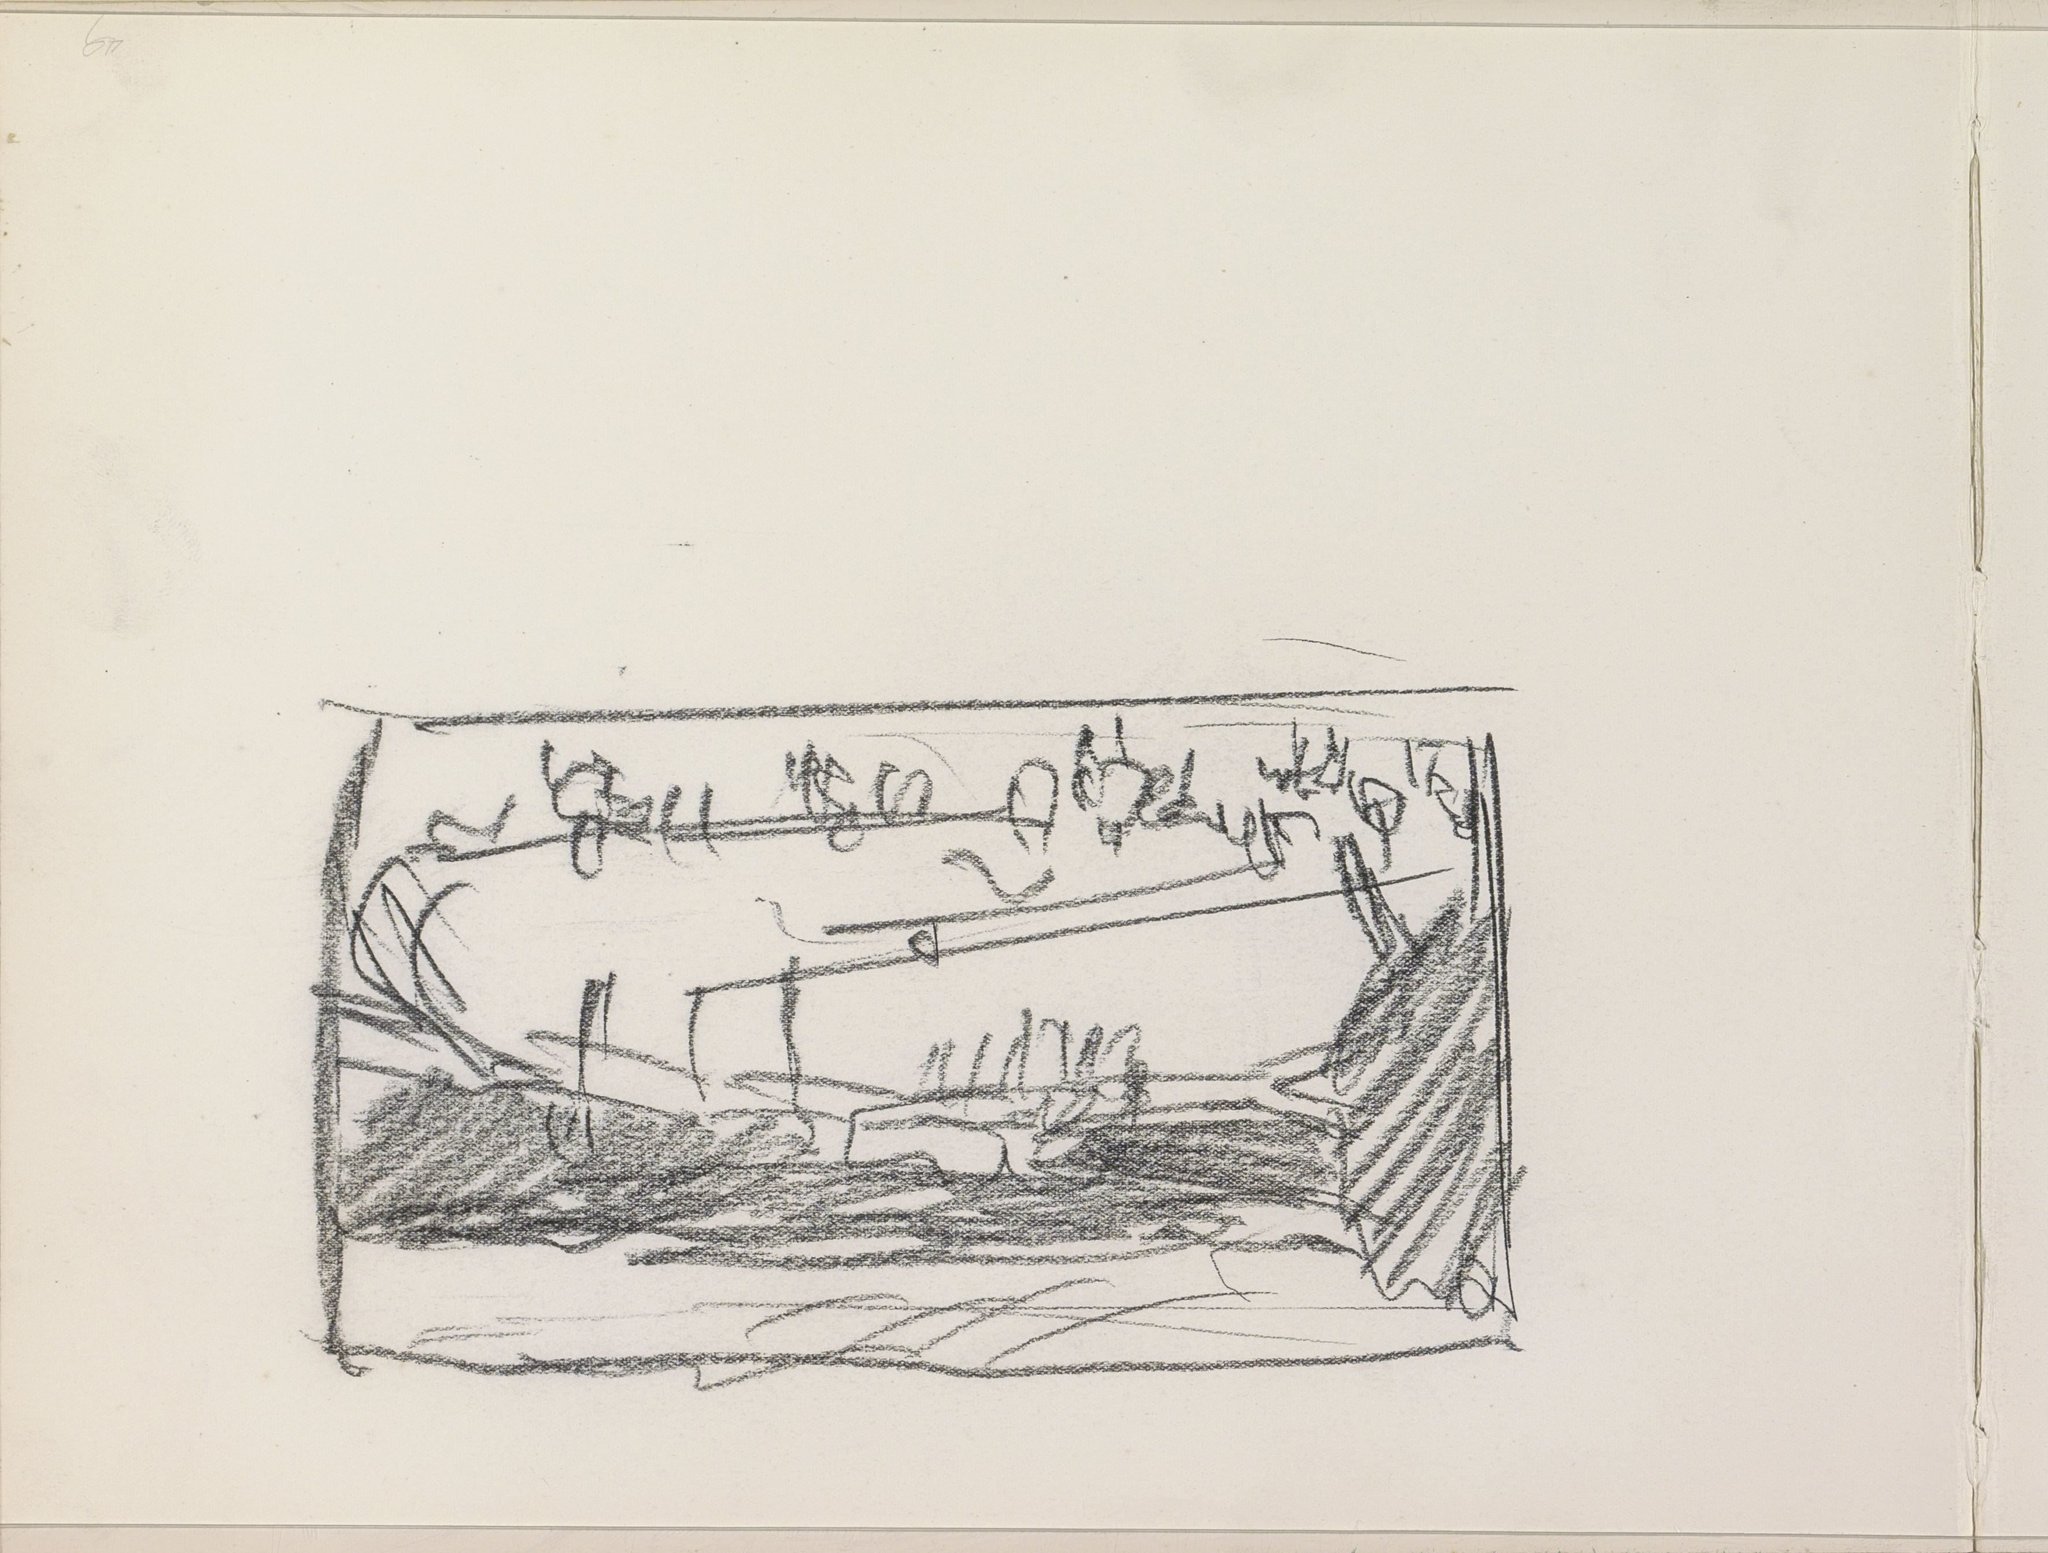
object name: sketchbook leaf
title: Compositiestudie van een landschap, mogelijk met paarden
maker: isaac israels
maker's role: draughtsman, painter, print maker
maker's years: 1865-1934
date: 1875-1934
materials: chalk, paper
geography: the hague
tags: landscapes in the temperate zone, horse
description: Blad 4 verso uit schetsboek VII met 26 bladen.